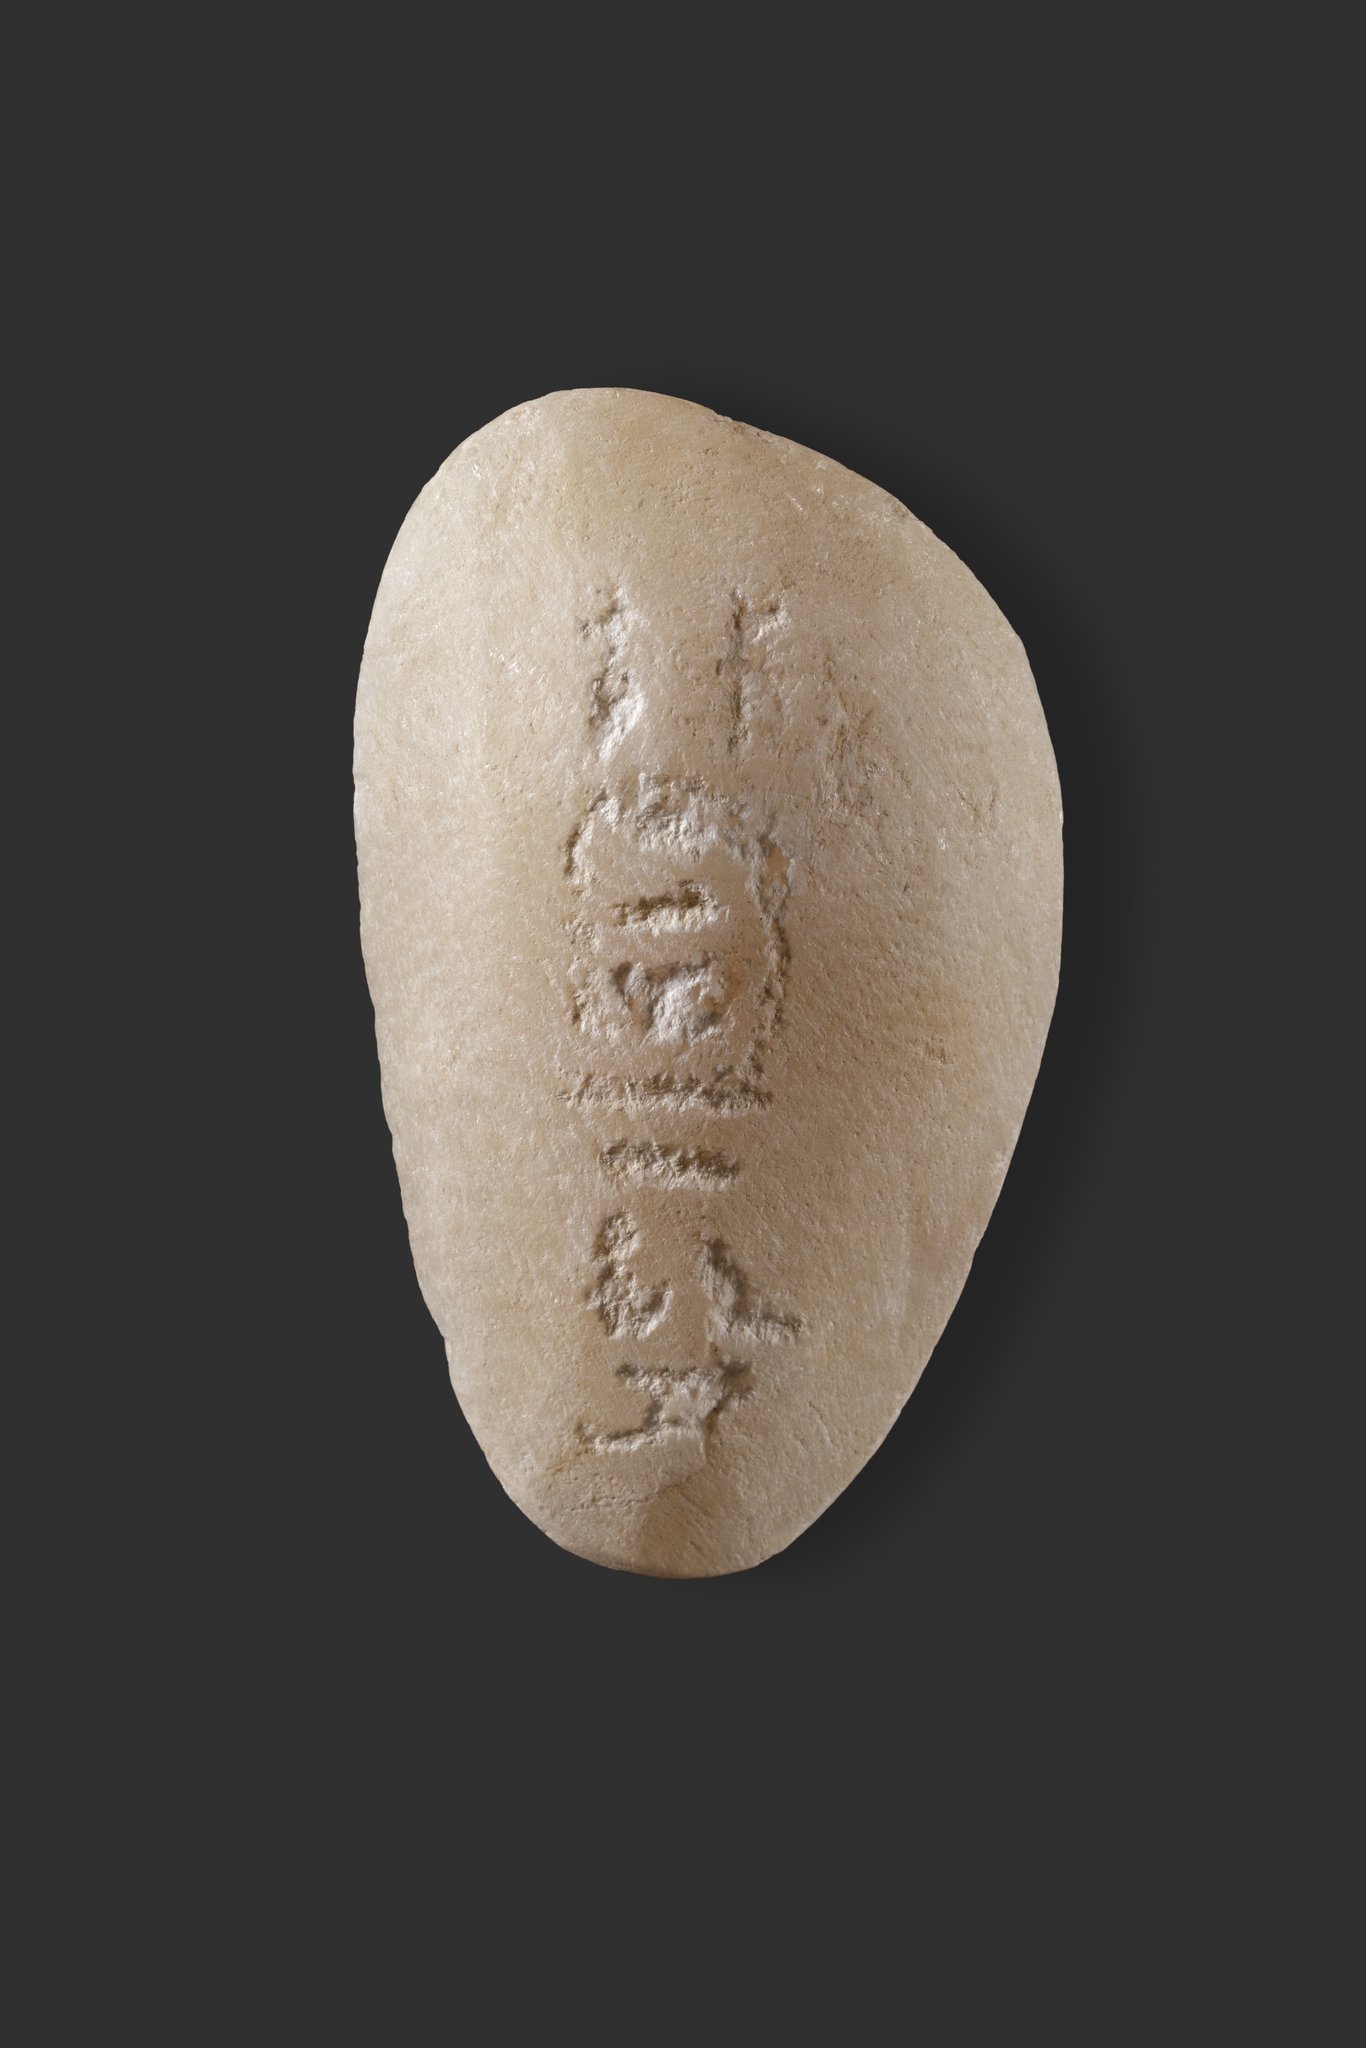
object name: bivavle, clam, mussel, unionid, foundation deposit, thutmose iii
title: Ritual Object Carved in the Shape of a Freshwater Mussel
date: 1479-1425 BCE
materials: stone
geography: egypt